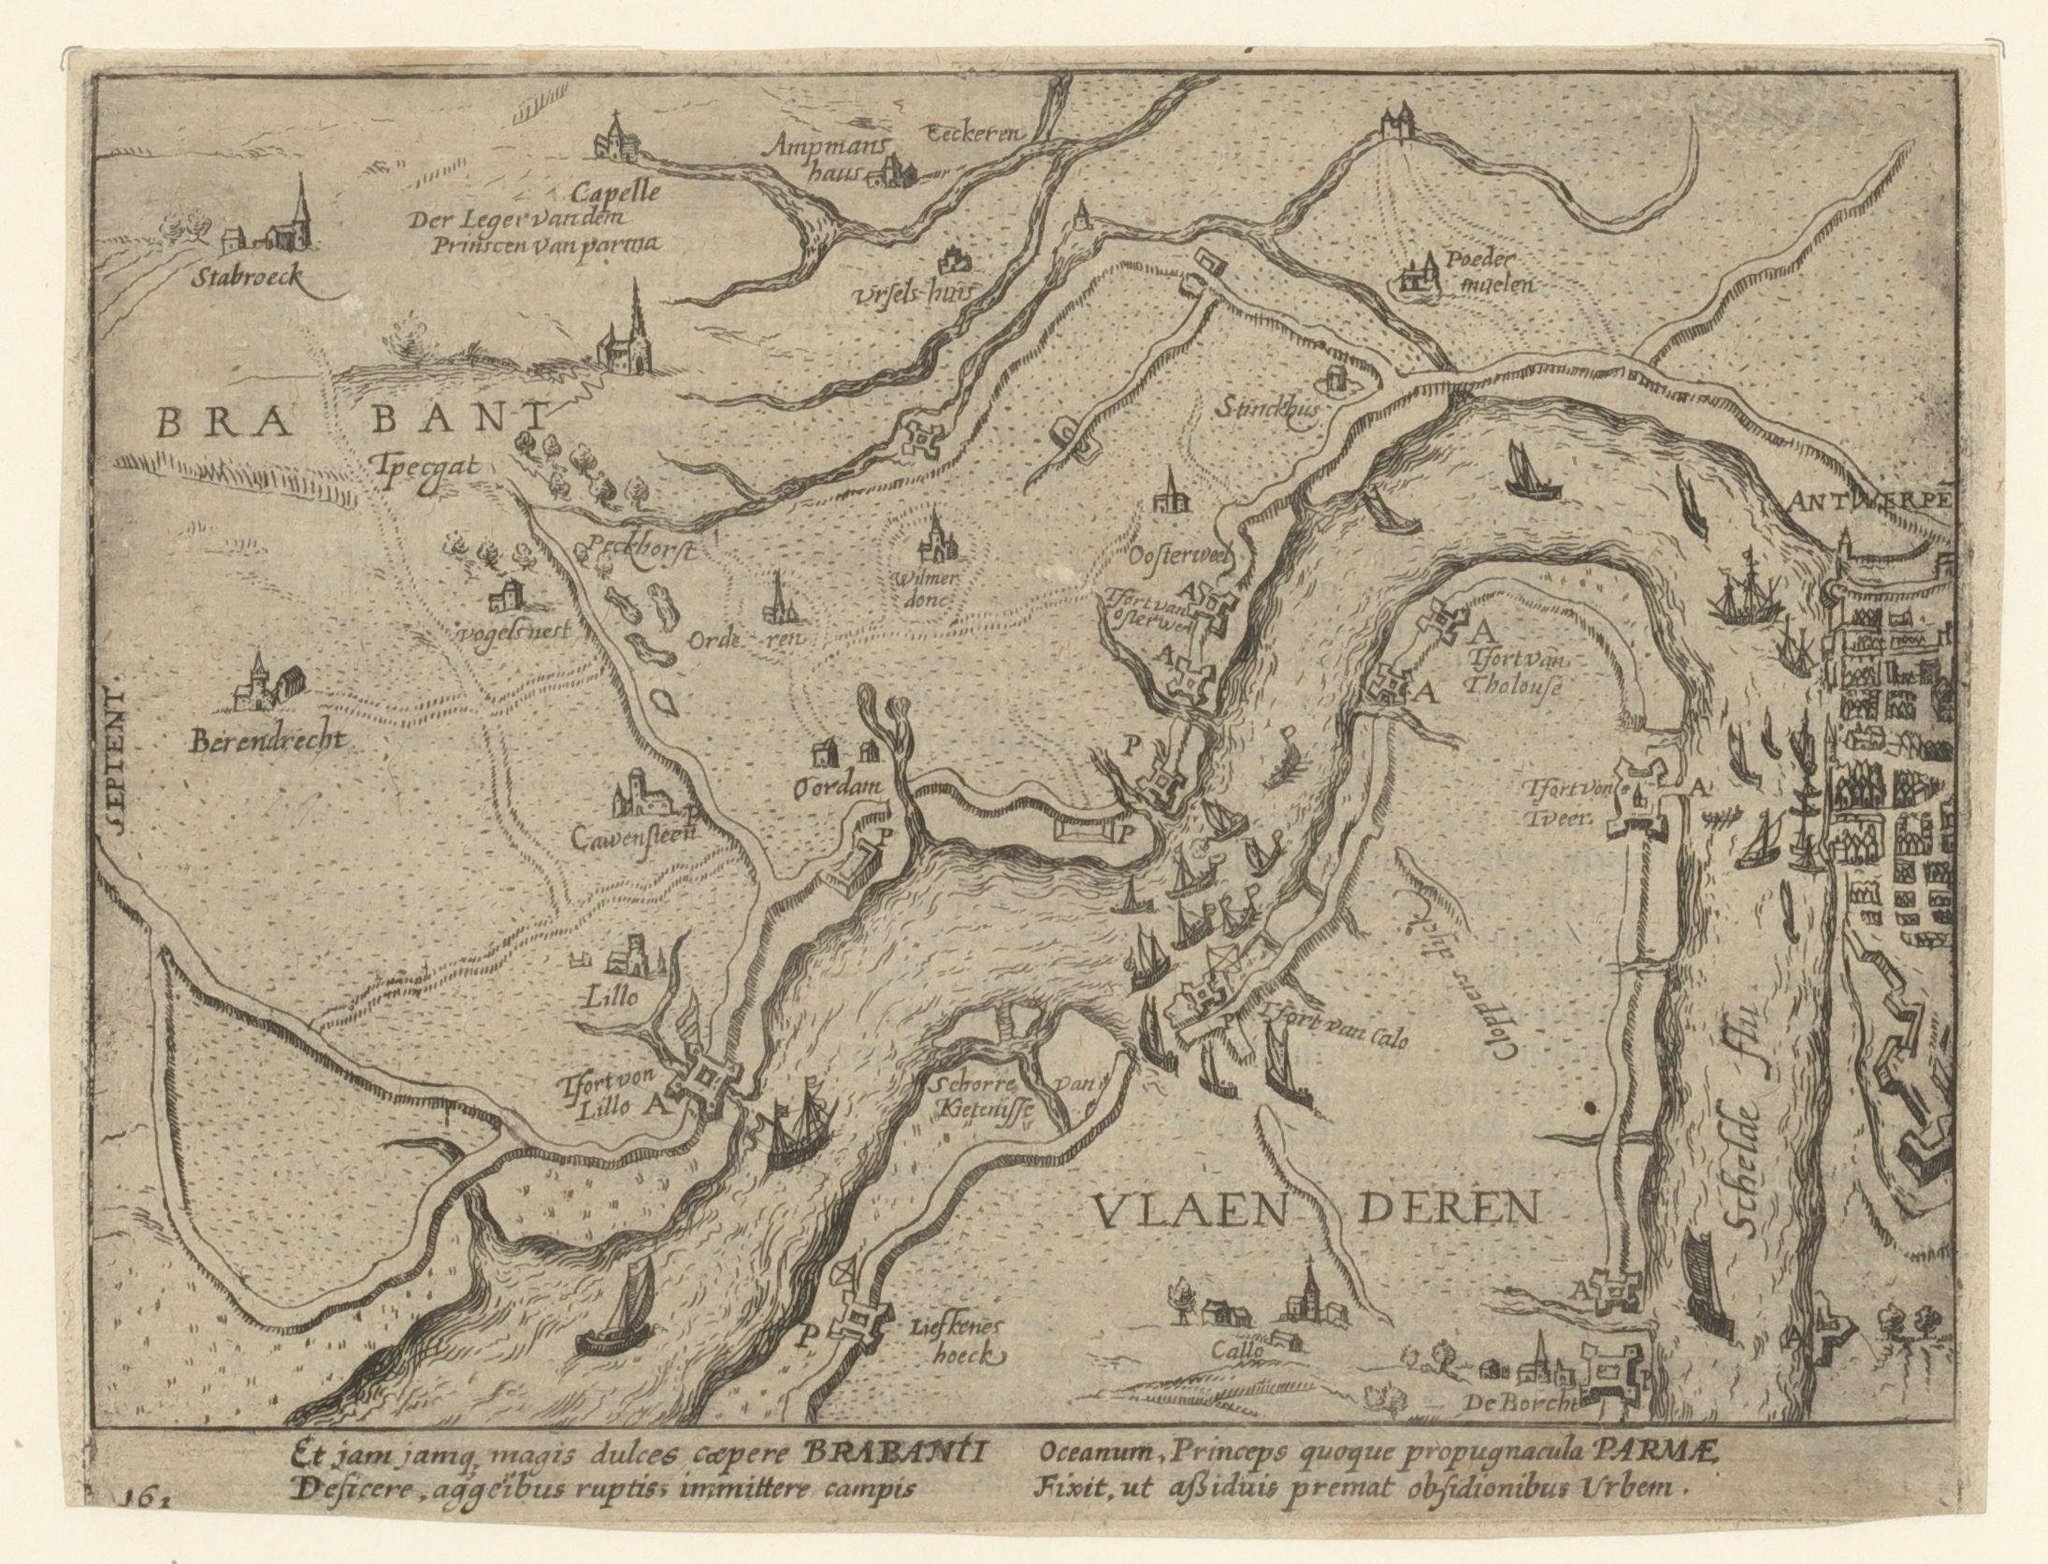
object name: book illustration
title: Beleg en inname van Antwerpen in 1584/1585: de schansen aan de Schelde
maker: Anonymous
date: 1613-1615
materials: paper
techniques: etching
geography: northern netherlands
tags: maps of separate countries or regions, fortifications, military engineering, antwerp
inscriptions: collector's mark: Lugt 1641, collector's mark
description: De schansen en forten om Antwerpen aan de Schelde. Onderdeel van een groep voorstellingen van het beleg en inname van Antwerpen door de hertog van Parma, juli 1584 tot 17 augustus 1585. Met onderschrift van 4 regels in het Latijn. Genummerd 163. Bedrukt op achterzijde met tekst in het Nederlands. Onderwerpsrubrieken binnen de Atlas Zeden en Gewoonten: Krijgswezen; prenten van Baudart. 80j. oorlog.